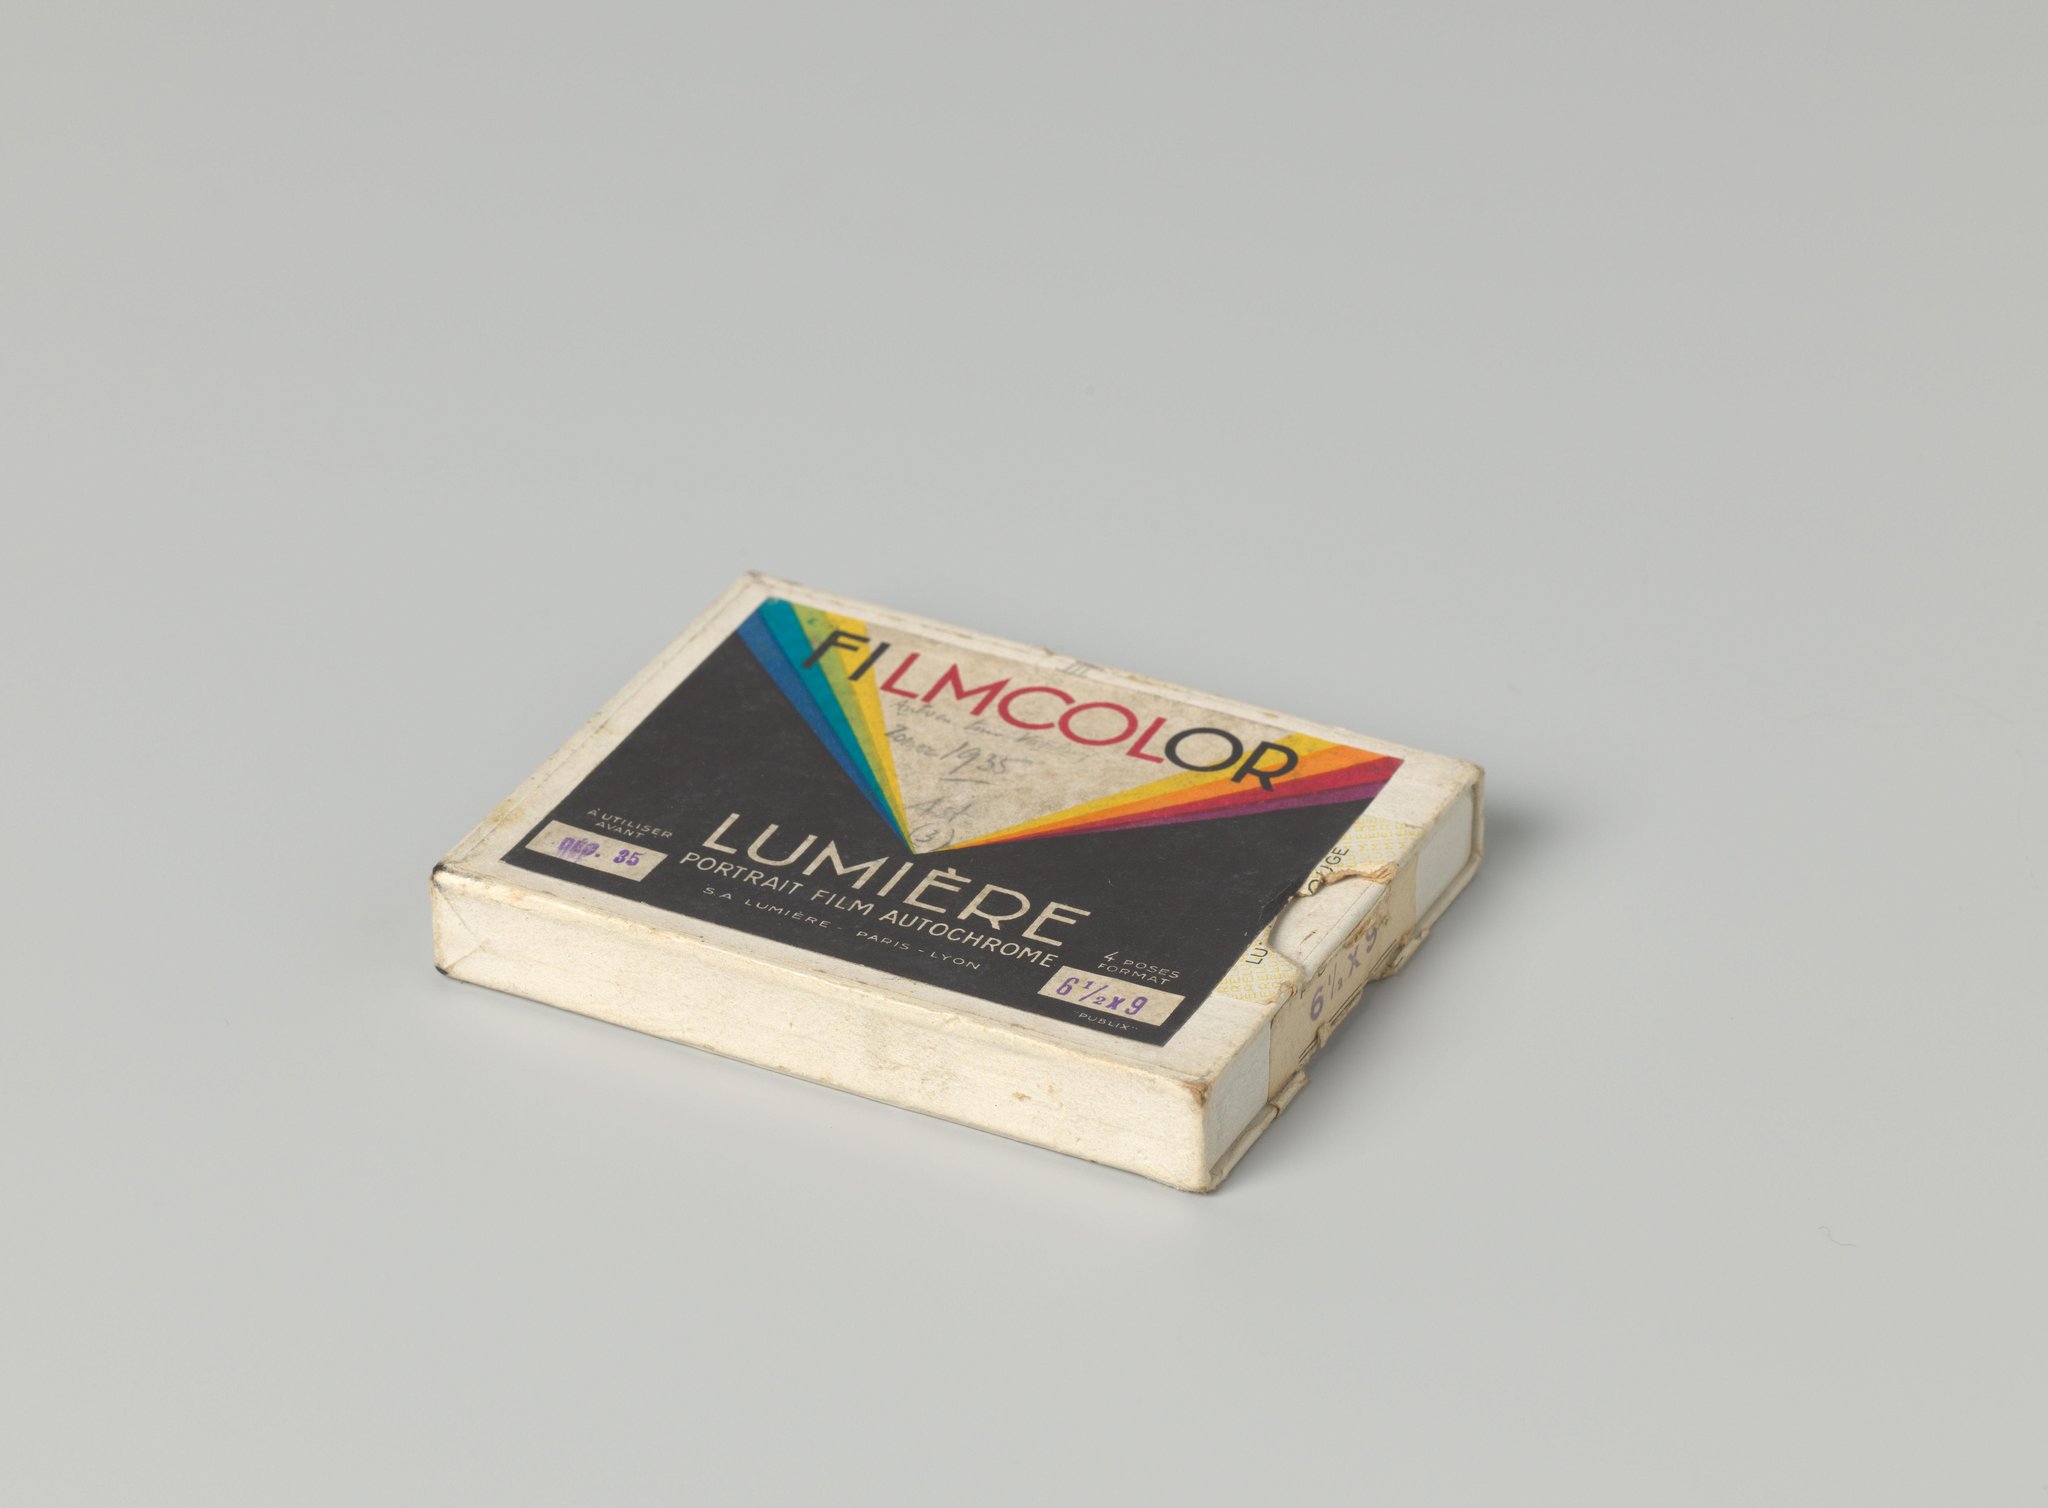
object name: box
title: Doos voor autochromes van Lumière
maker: lumière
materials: cardboard, paper, tape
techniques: printing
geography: france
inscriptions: date: ‘À UTILISER/ AVANT/ DEC. 35’, inscription: ‘III/ Auto en huis Voorburg/ Zomer 1935/ 1st (3)’